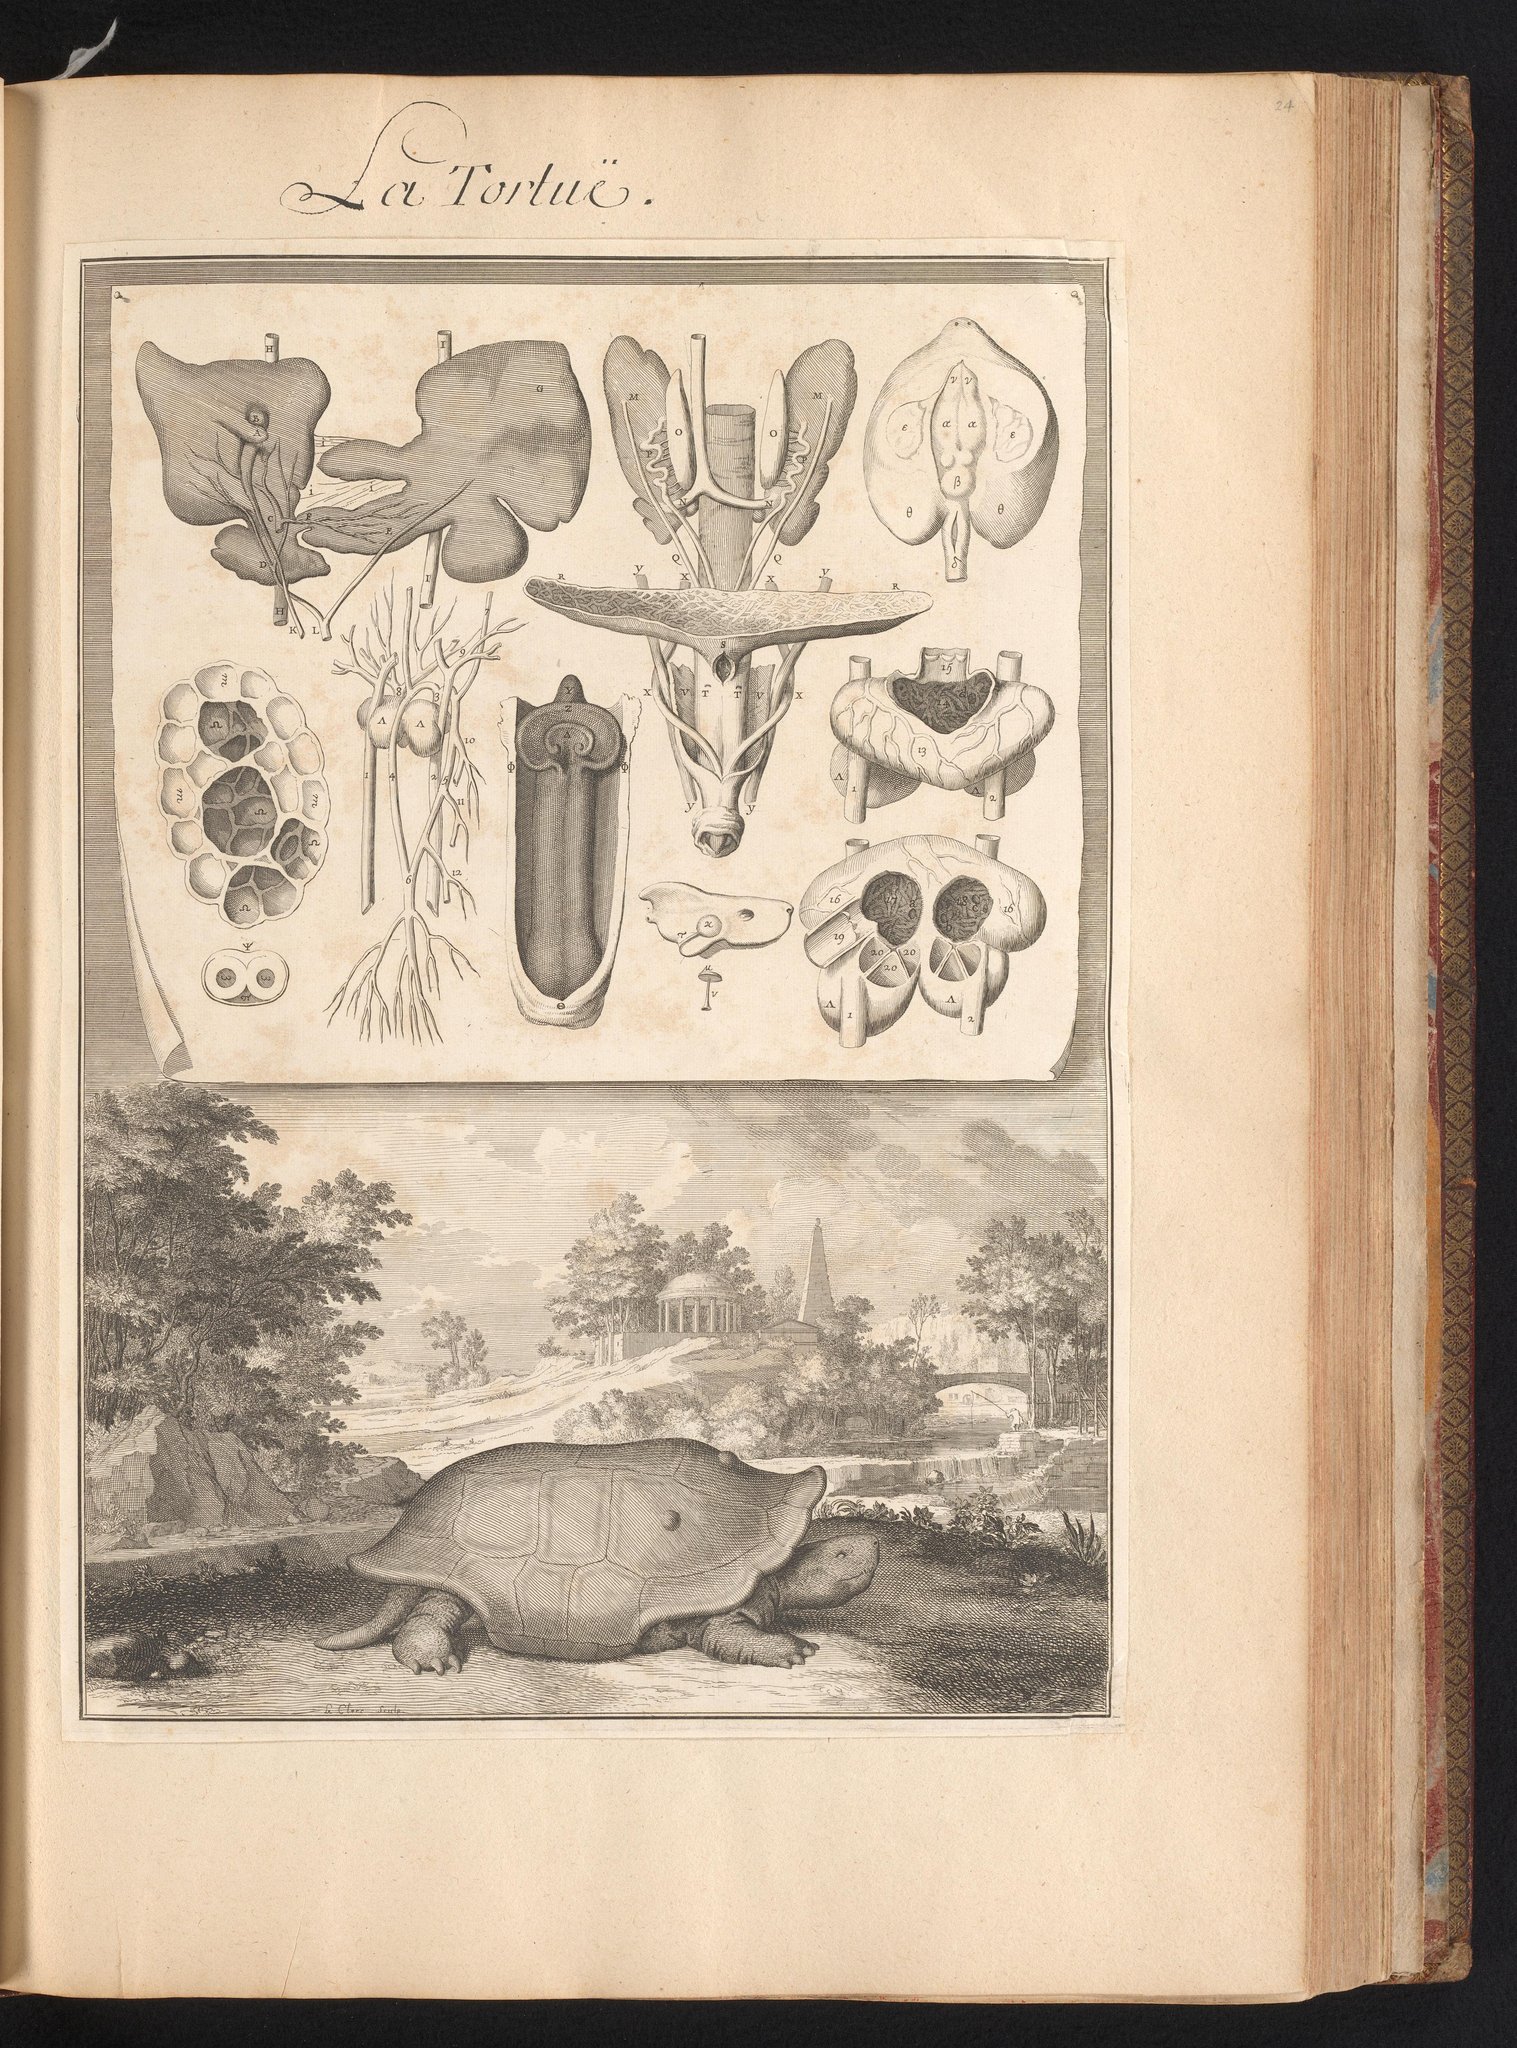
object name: book illustration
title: Schildpad in een landschap met bovenaan op een blad de organen van het dier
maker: sébastien leclerc (i)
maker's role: print maker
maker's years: 1637-1714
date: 1676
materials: ink, paper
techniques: engraving, etching, pen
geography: paris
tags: dissection, tortoises, turtles, animals (+ anatomy of animals)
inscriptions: inscription: ‘La Tortuë.’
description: Prent uit: Perrault, Claude. Mémoires pour servir à l'histoire naturelle des animaux. Dressez par M. Perrault de l'Académie Royale des Sciences (...). Parijs: Imprimerie Royale, 1676.